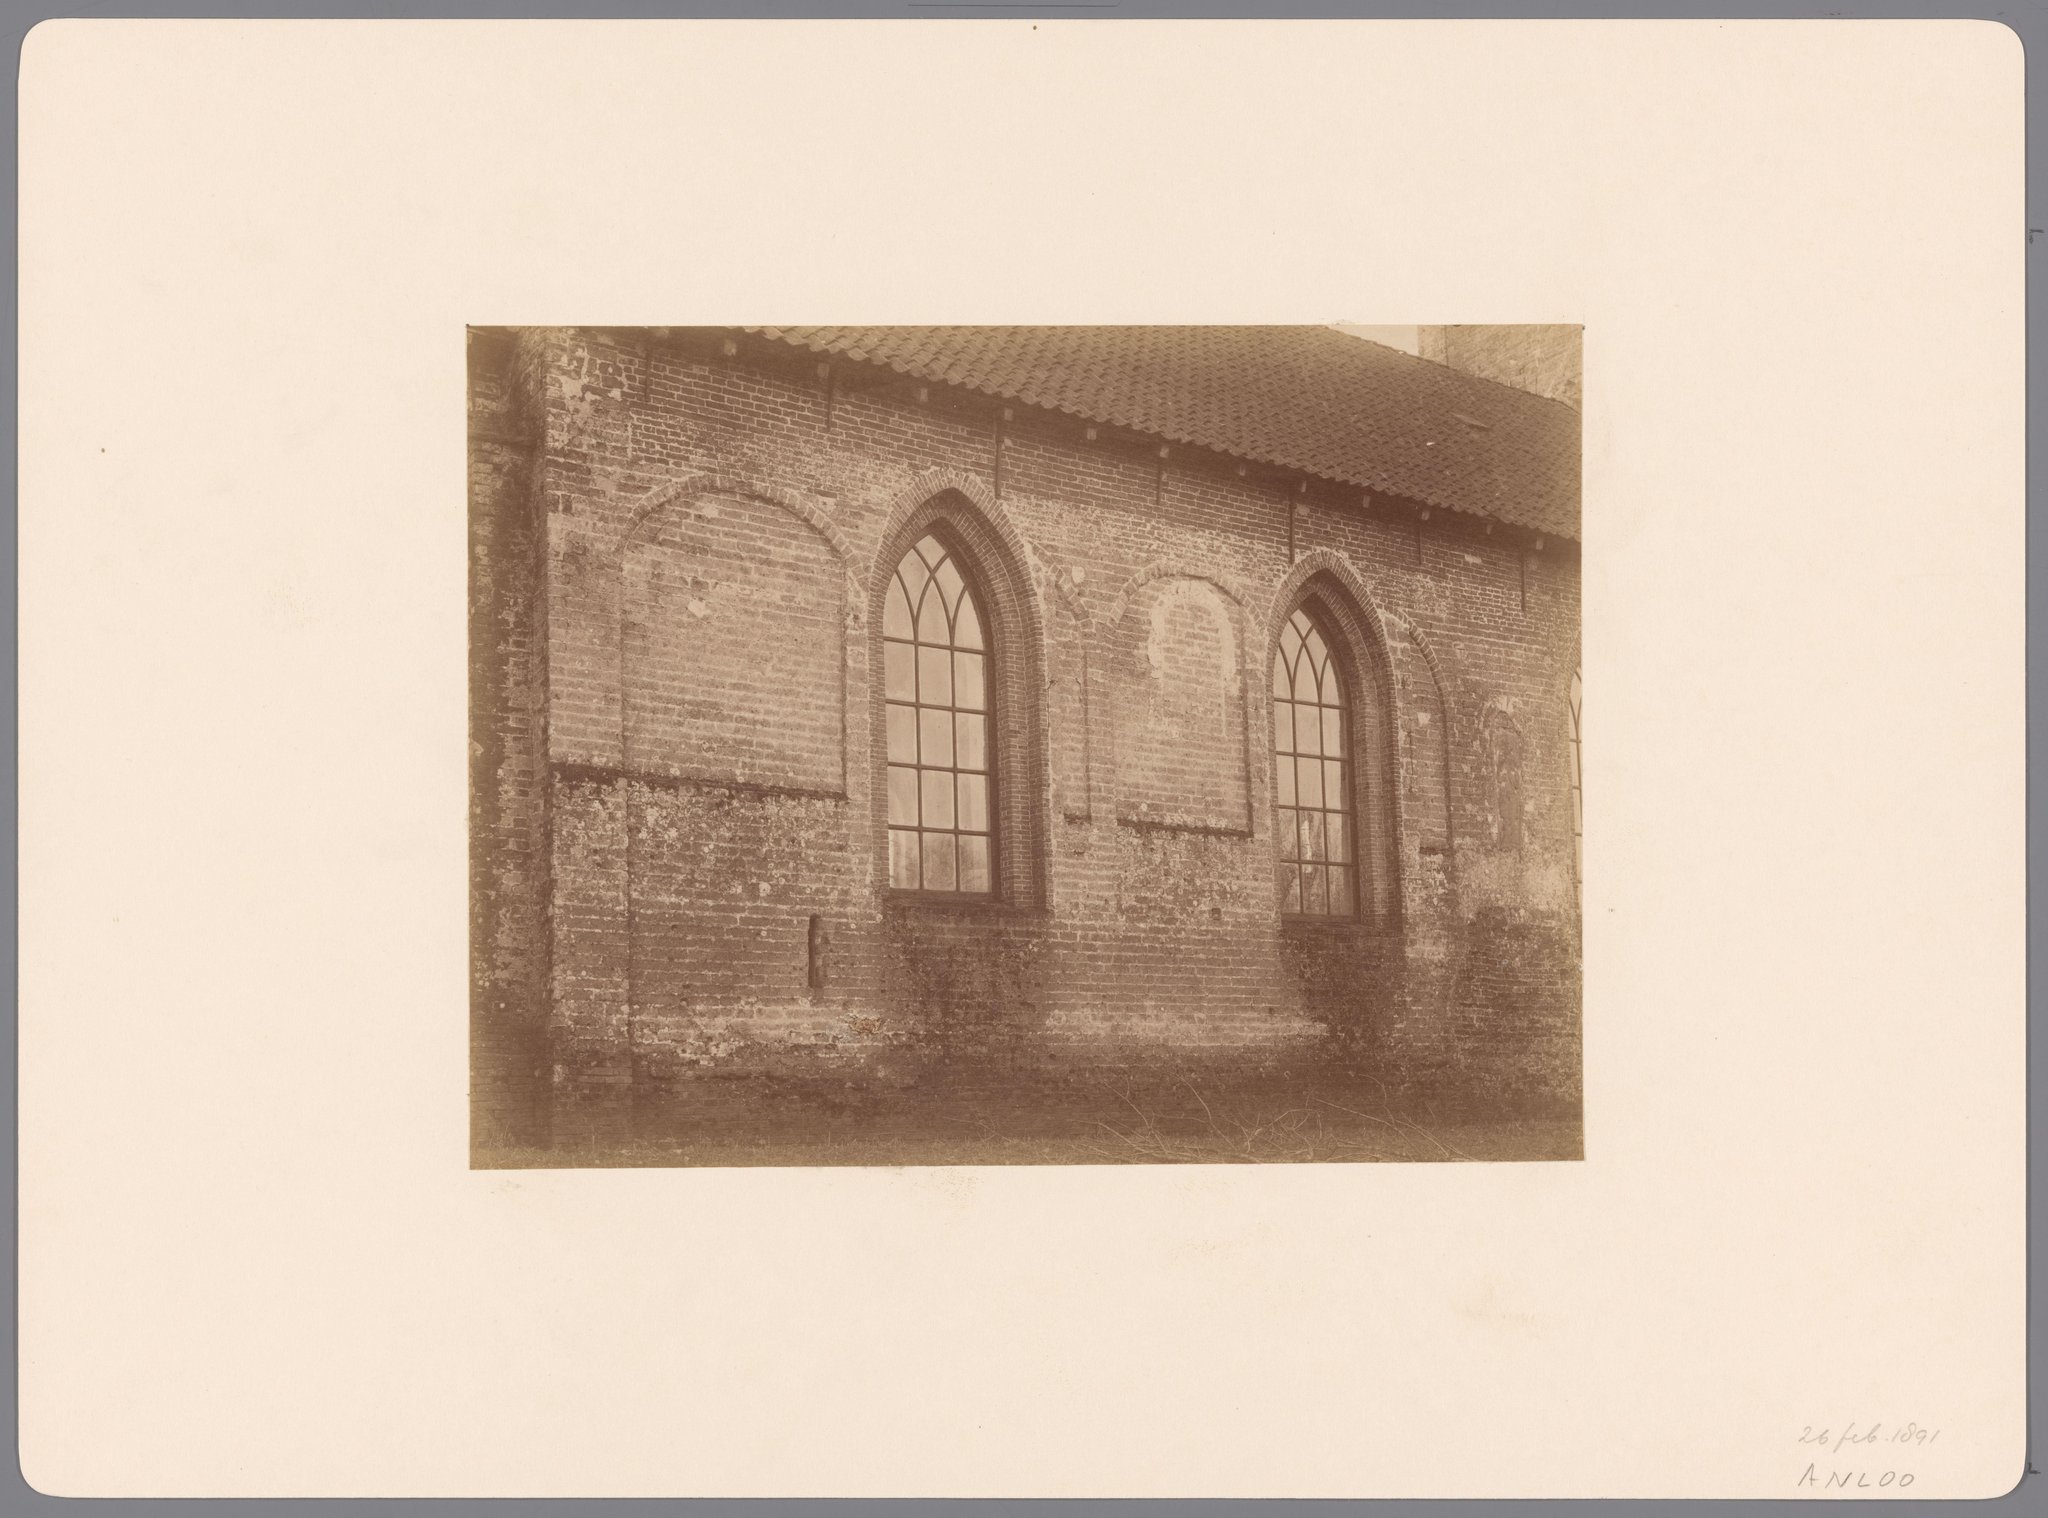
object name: photograph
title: Noordzijde van de Magnuskerk te Anloo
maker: anoniem (monumentenzorg)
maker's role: fotograaf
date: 1891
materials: cardboard, photographic support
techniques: albumen print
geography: anloo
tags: church (exterior)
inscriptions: annotation: ‘6’, annotation: ‘26 feb. 1891/ Anloo’